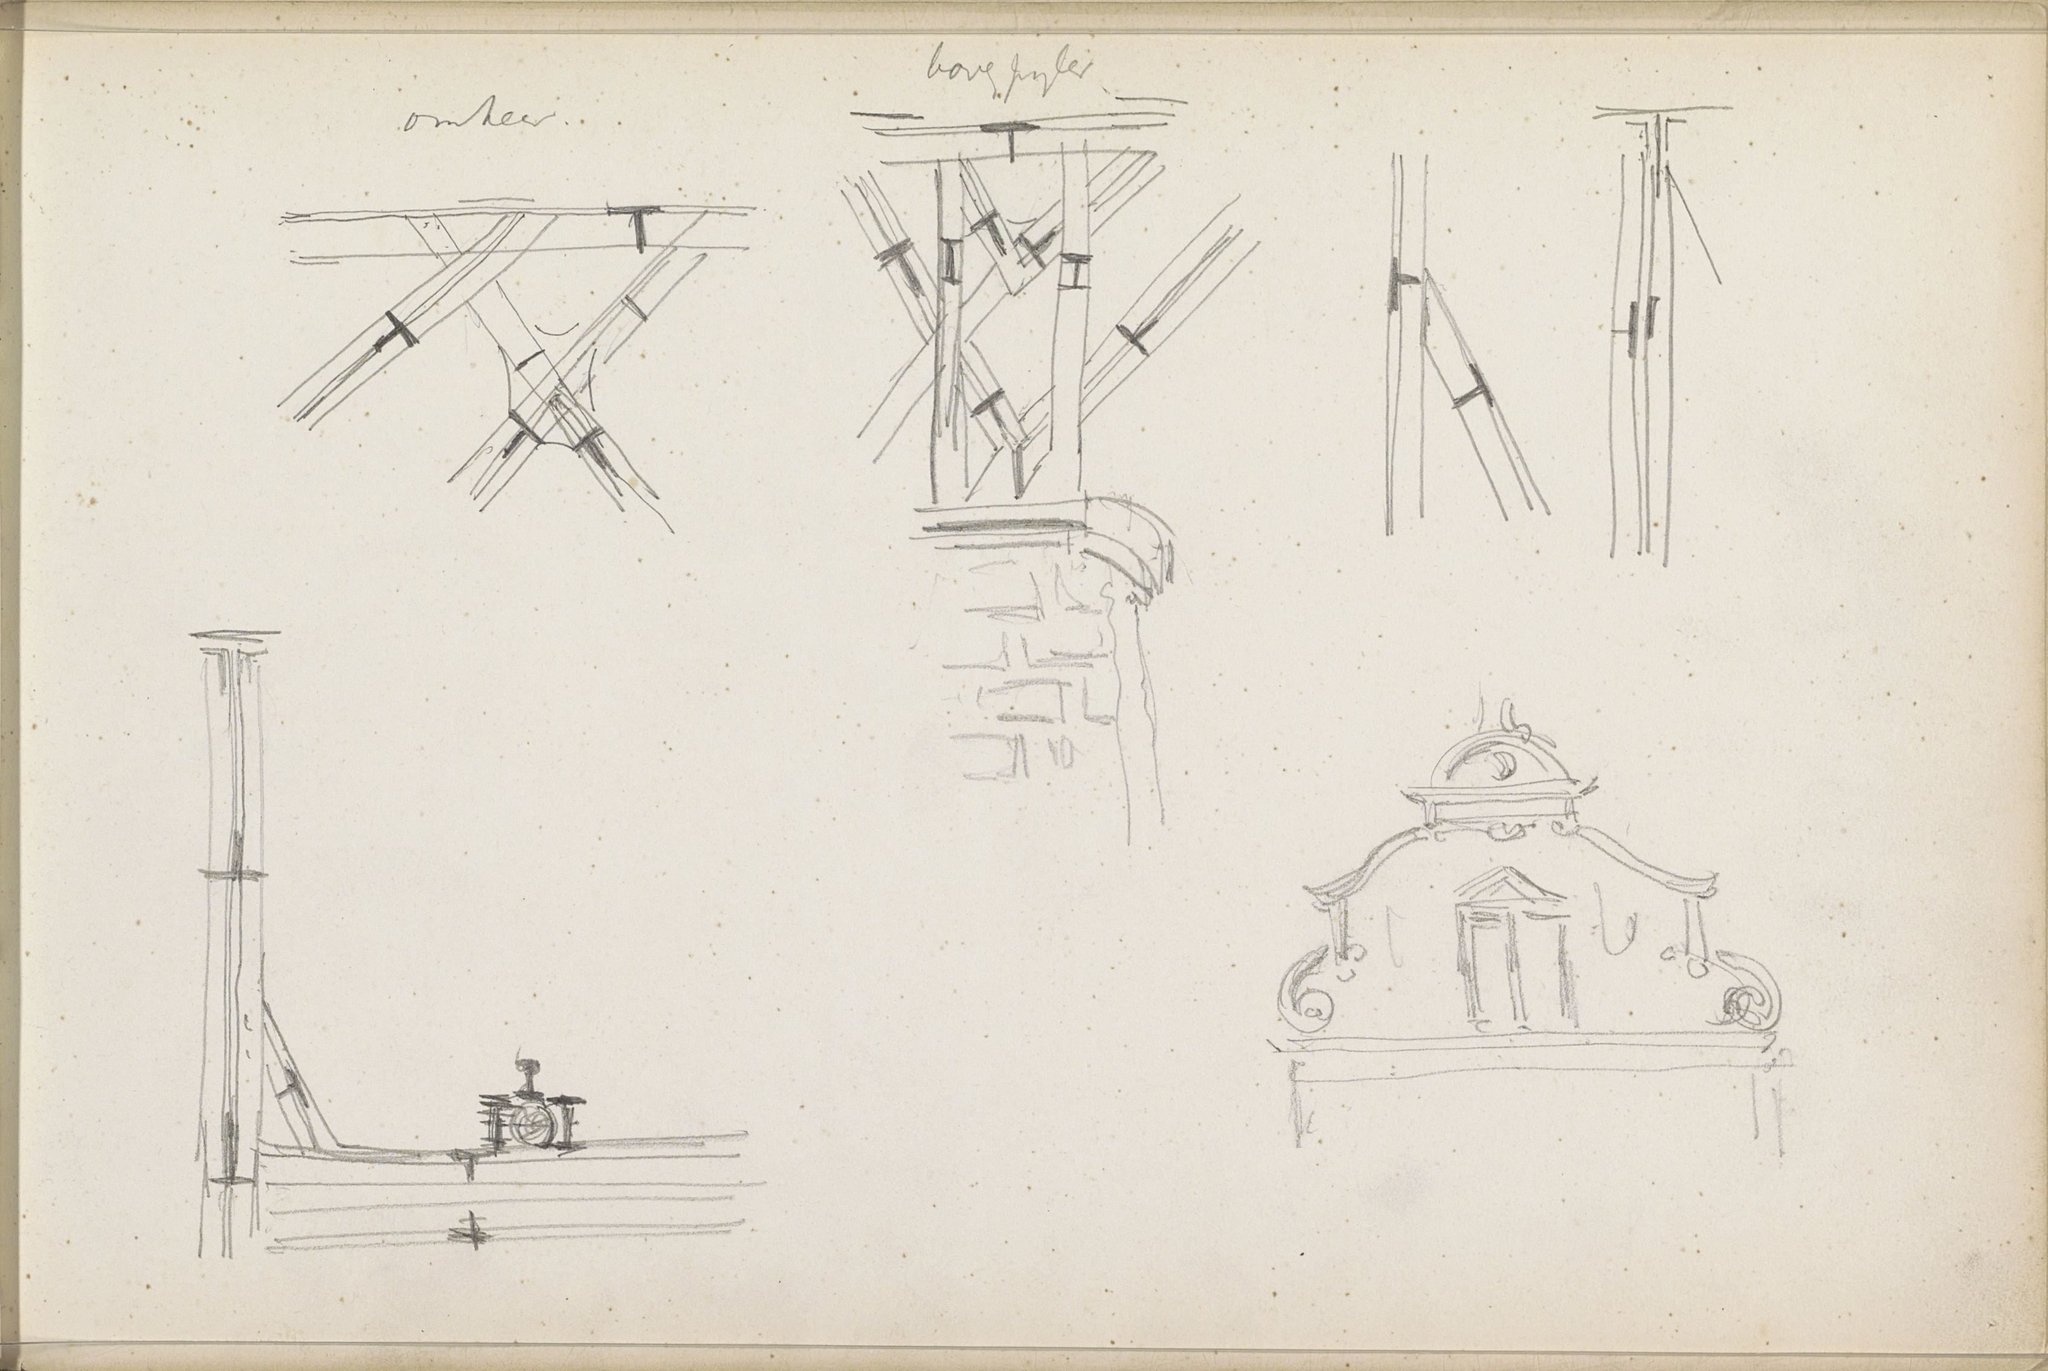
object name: sketchbook leaf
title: Houtconstructies en een klokgevel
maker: isaac gosschalk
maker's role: draughtsman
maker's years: 1838-1907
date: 1862-1867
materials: paper, pencil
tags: wood, timber ~ building material, exterior ~ representation of a building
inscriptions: annotation: ‘okeer bo[...]er’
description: Blad 28 recto uit een schetsboek met 58 bladen.